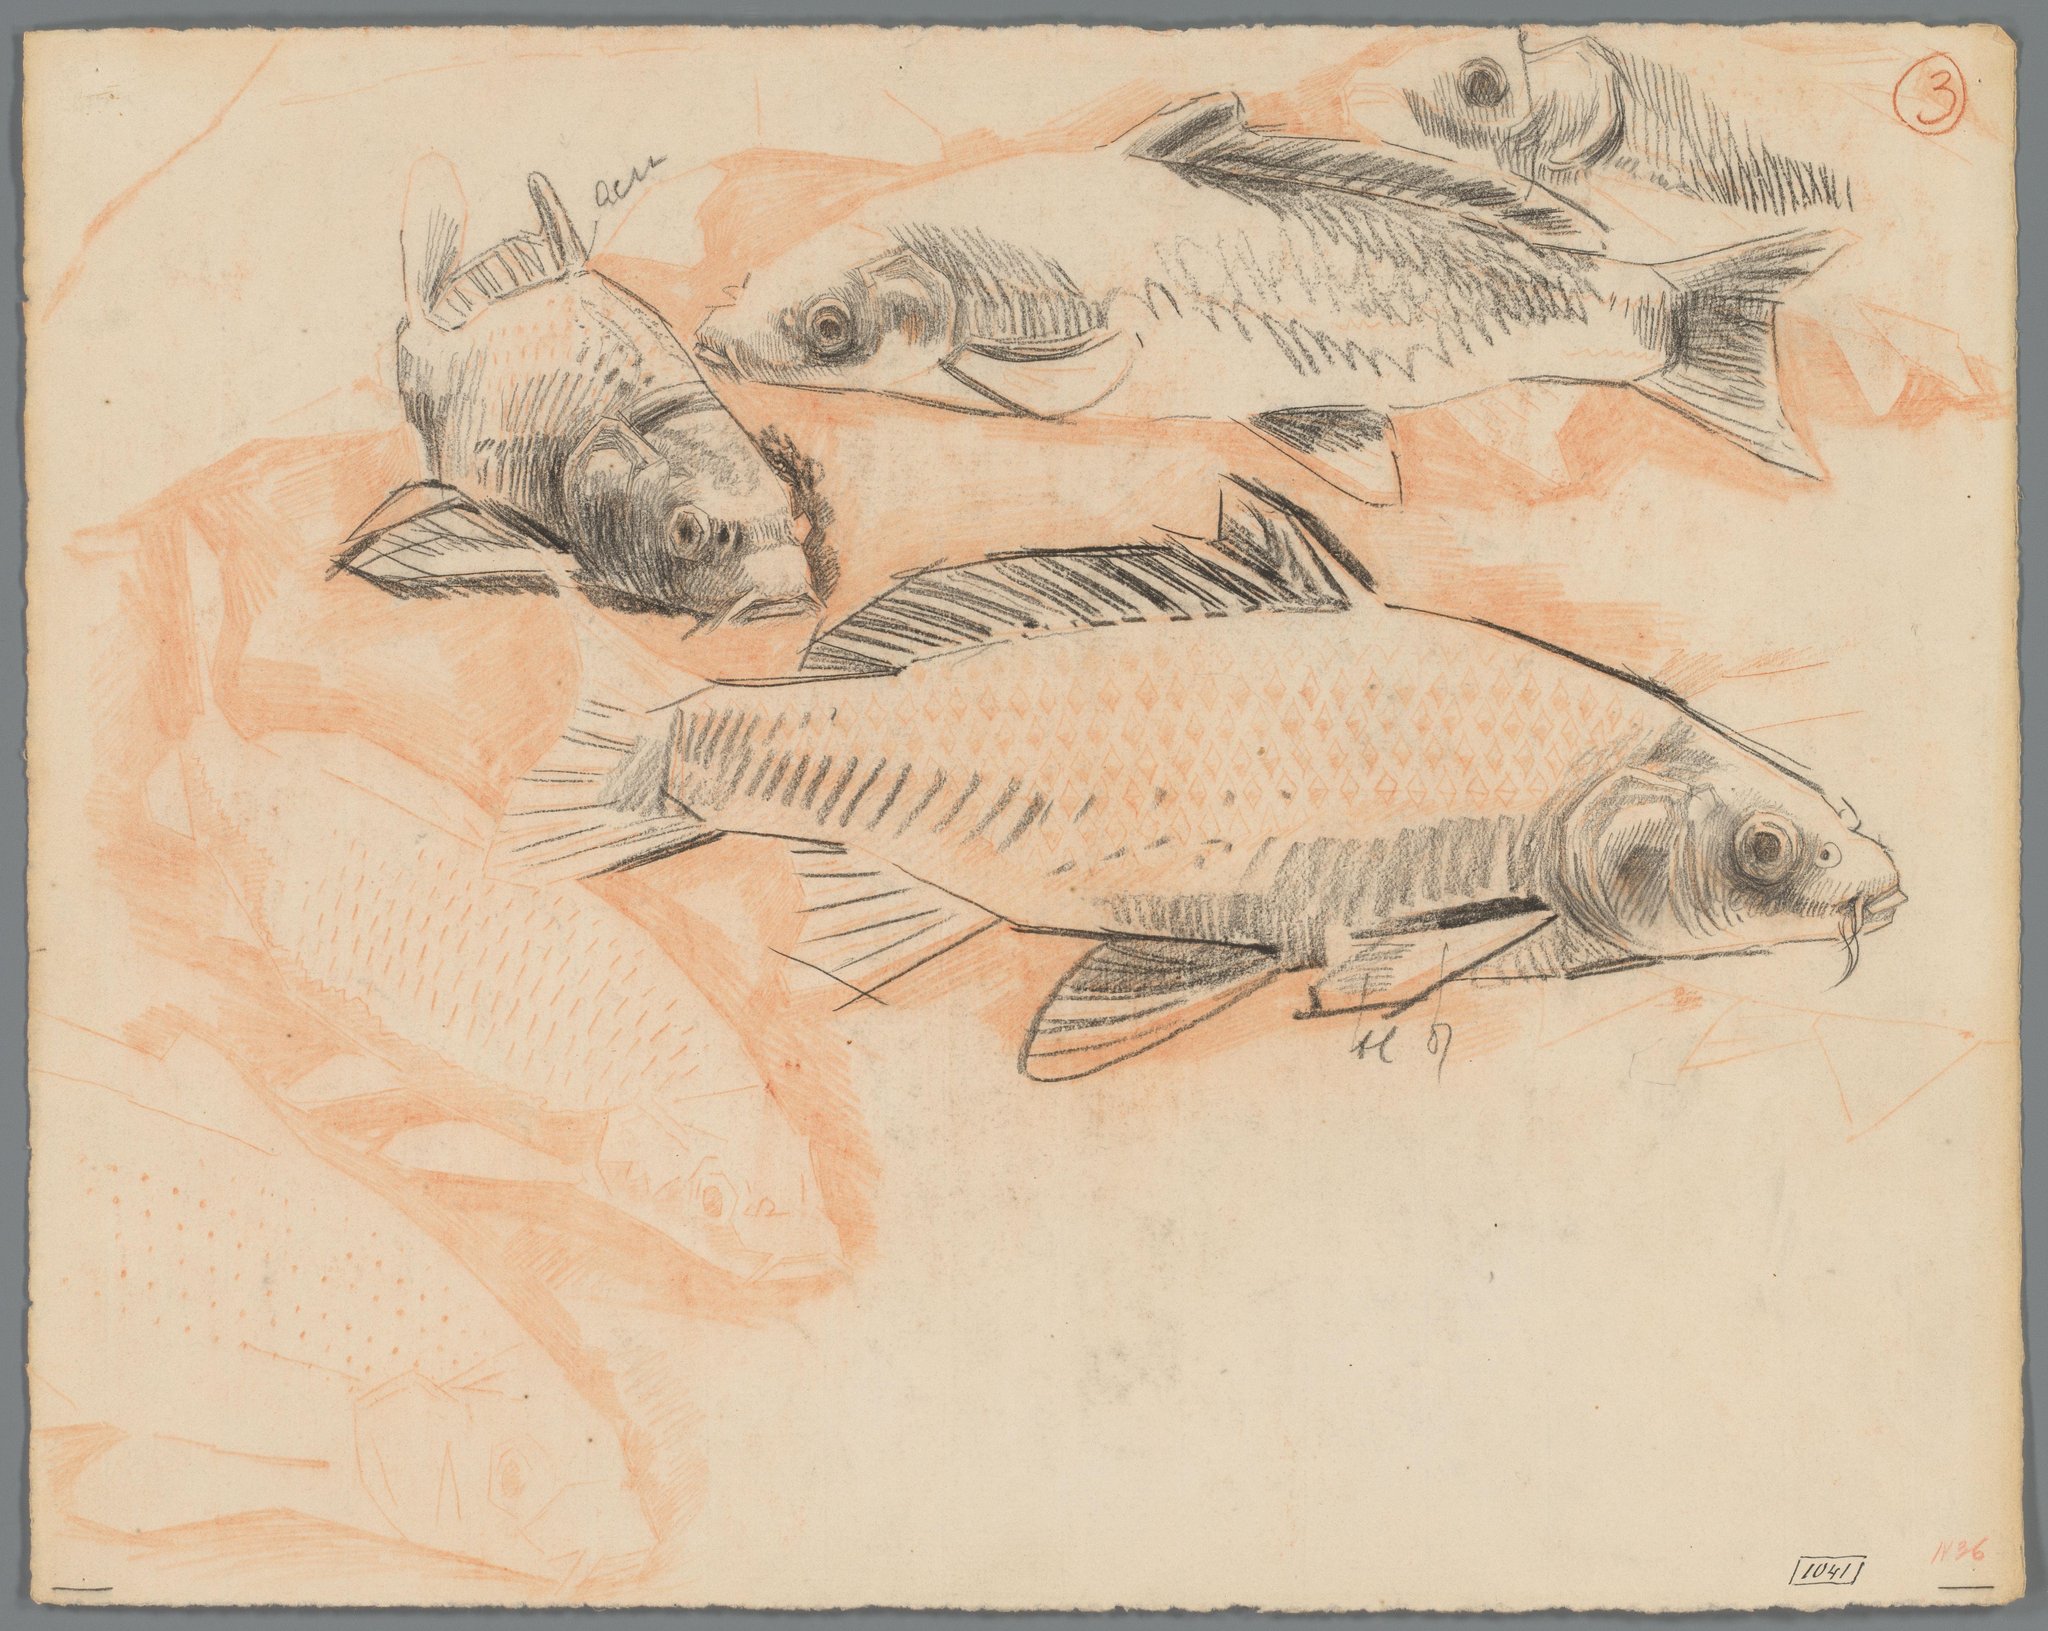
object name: drawing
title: Studies van karpers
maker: gerrit willem dijsselhof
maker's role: designer, draughtsman, print maker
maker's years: 1866-1924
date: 1876-1924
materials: chalk, paper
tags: bony fishes: carp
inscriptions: number: ‘1041’